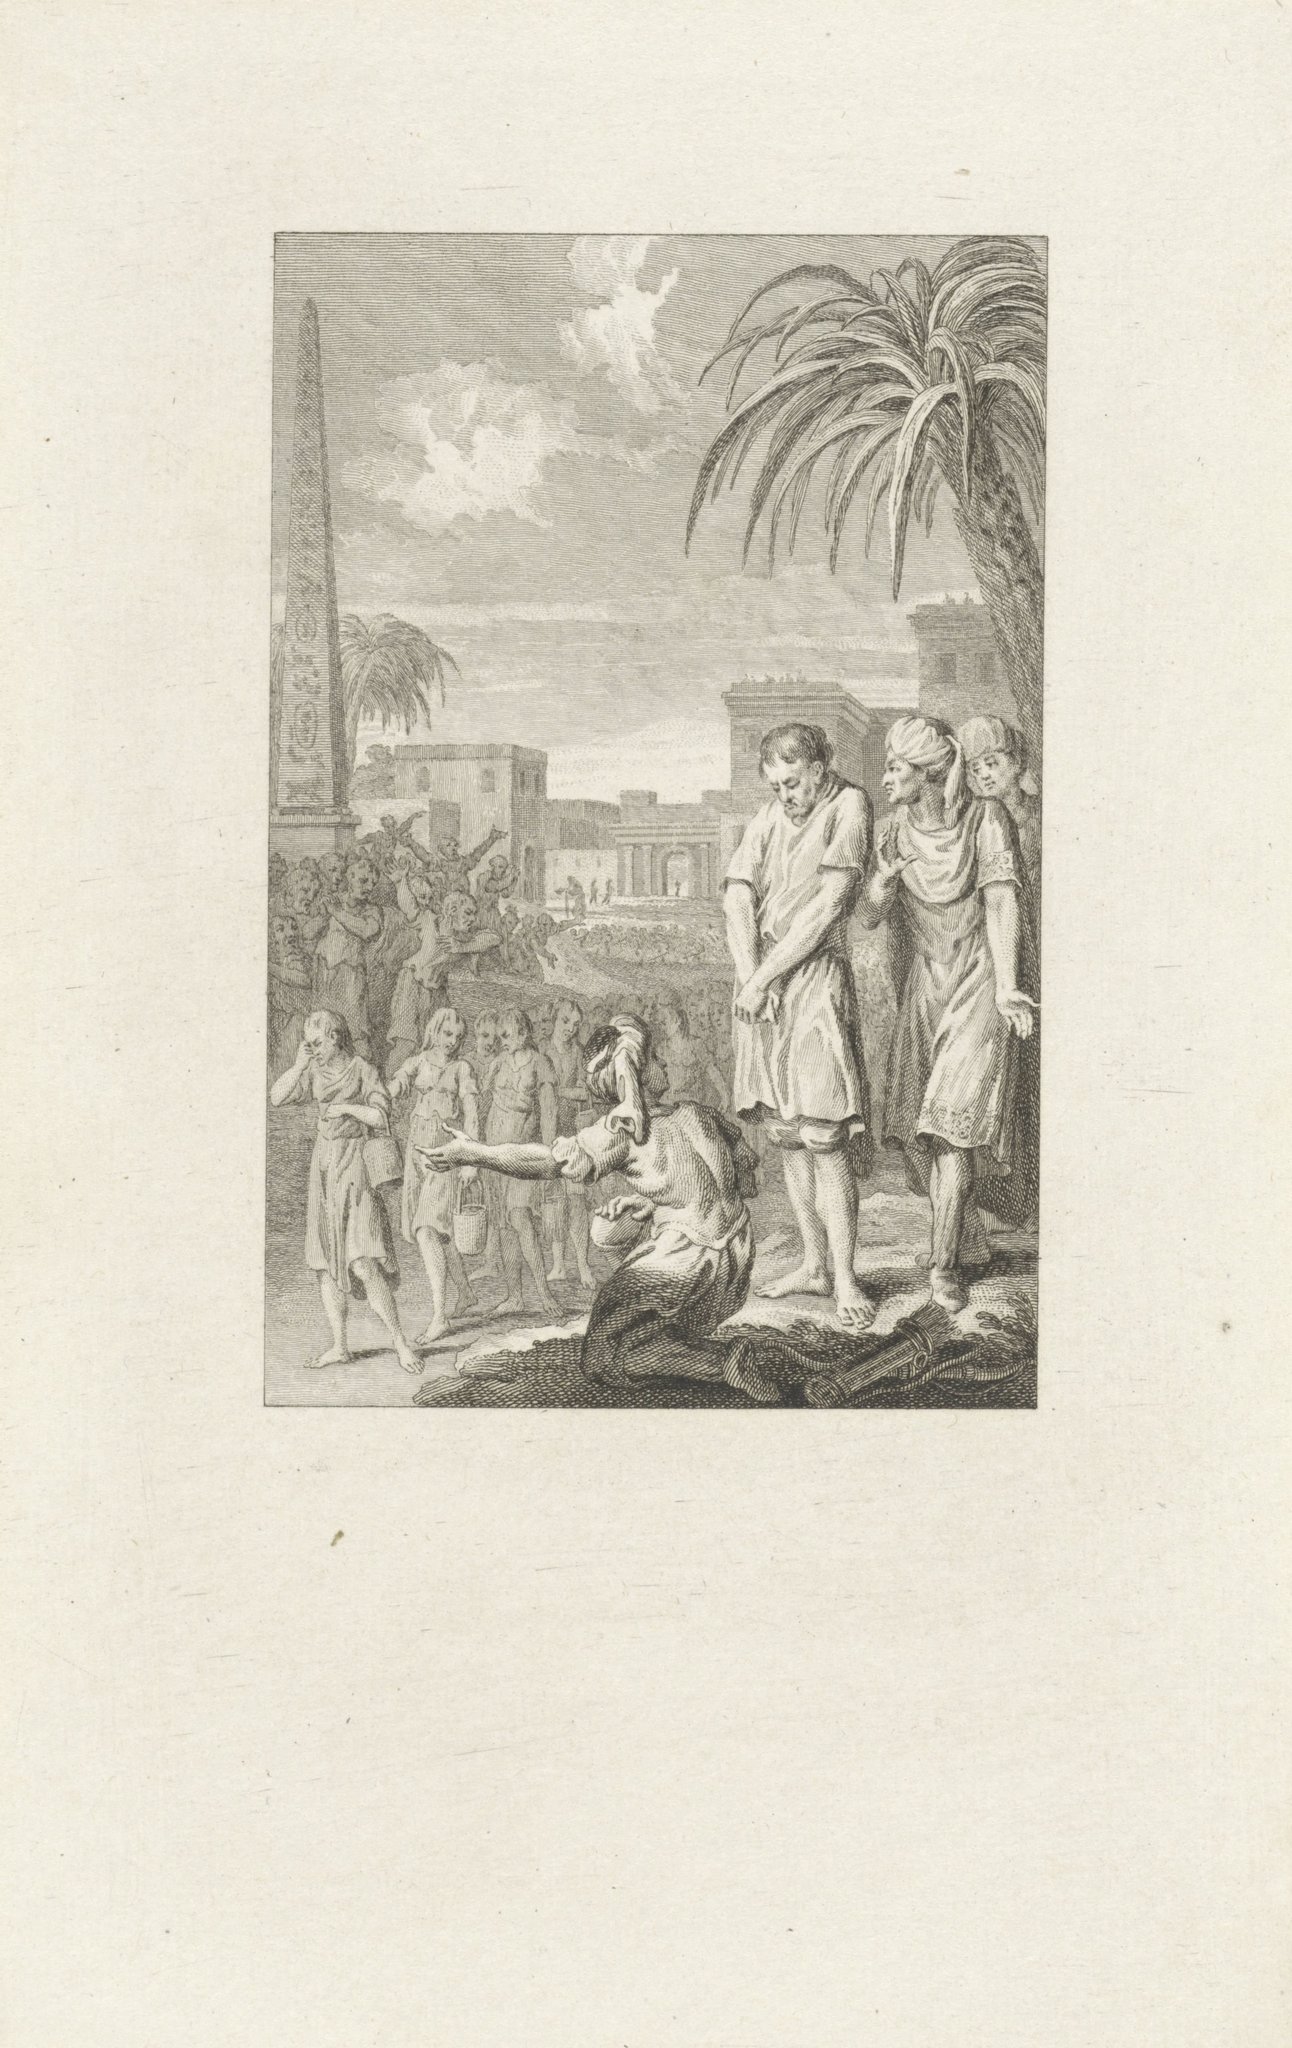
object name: print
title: Psammetichus III gevangen genomen door Cambyses II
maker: reinier vinkeles (i)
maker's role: draughtsman, print maker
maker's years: 1741-1816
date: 1780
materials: paper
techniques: engraving, etching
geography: amsterdam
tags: obelisk, needle, slavery; serfs and enslaved persons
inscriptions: collector's mark: Lugt 240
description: De Egyptische farao Psammetichus III, gevangen genomen door de Perzische koning Cambyses II, wordt gedwongen zijn dochter en zoon als slaafgemaakten langs te zien lopen.